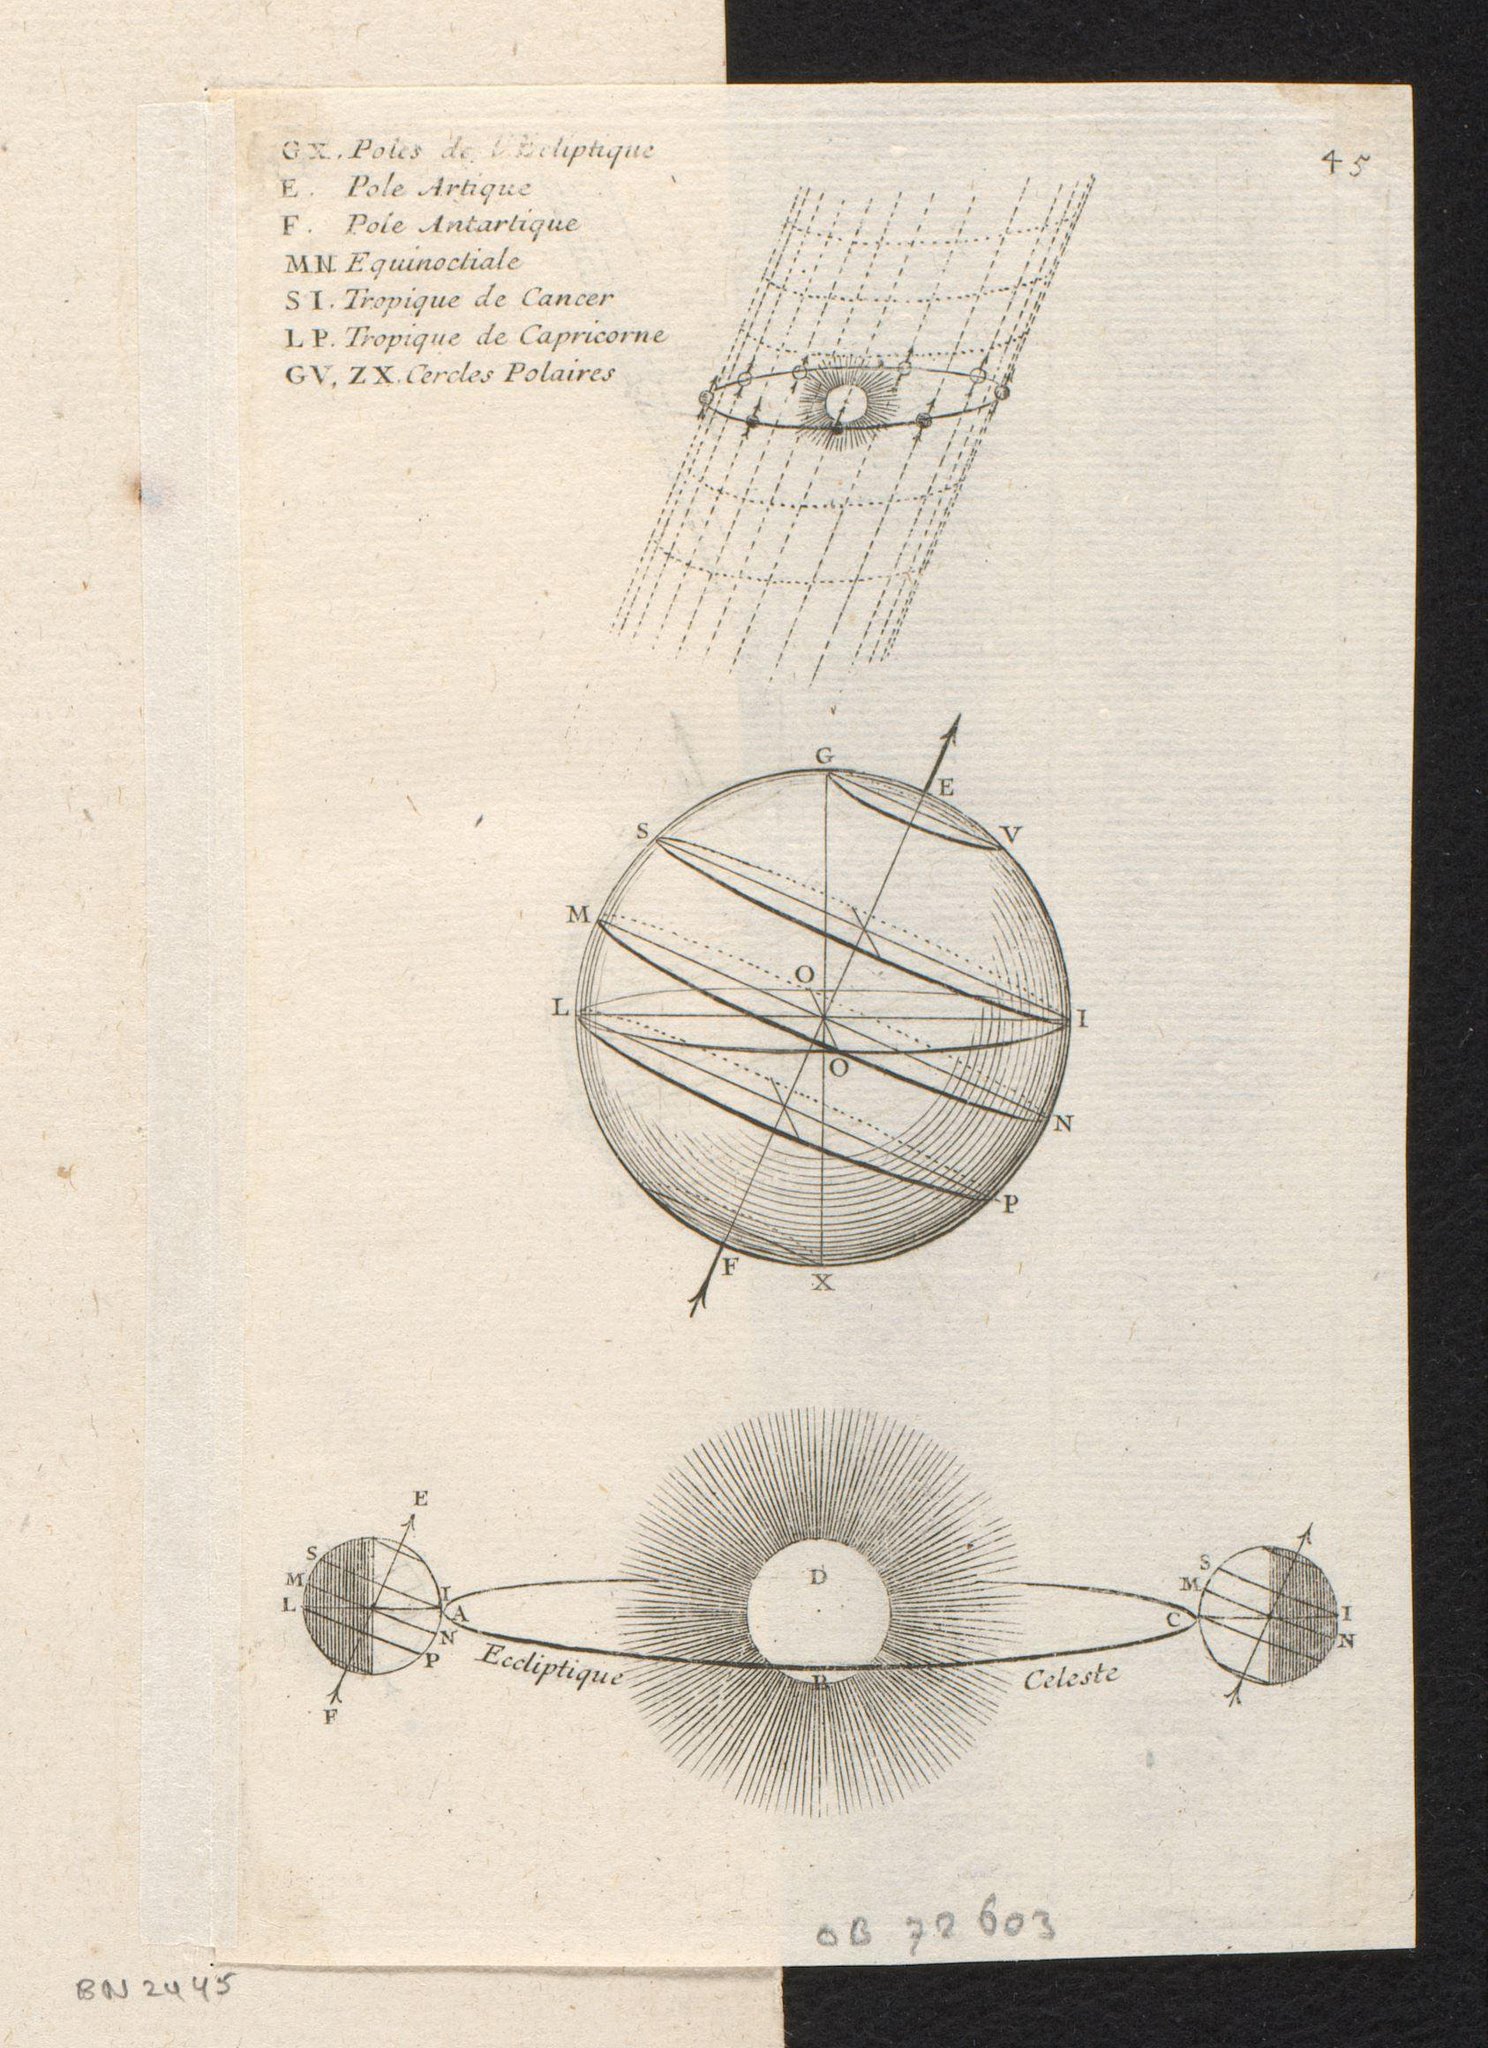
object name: book illustration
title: Helling van de Aarde ten opzichte van de ecliptica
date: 1706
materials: paper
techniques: etching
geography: france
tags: earth, world as celestial body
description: Prent uit: Leclerc, Sébastien. Nouveau systeme du monde conforme à l'Ecriture sainte. Où les phénomènes sont expliquez sans excentricité de mouvement (...). Paris: Pierre Giffart, 1706.